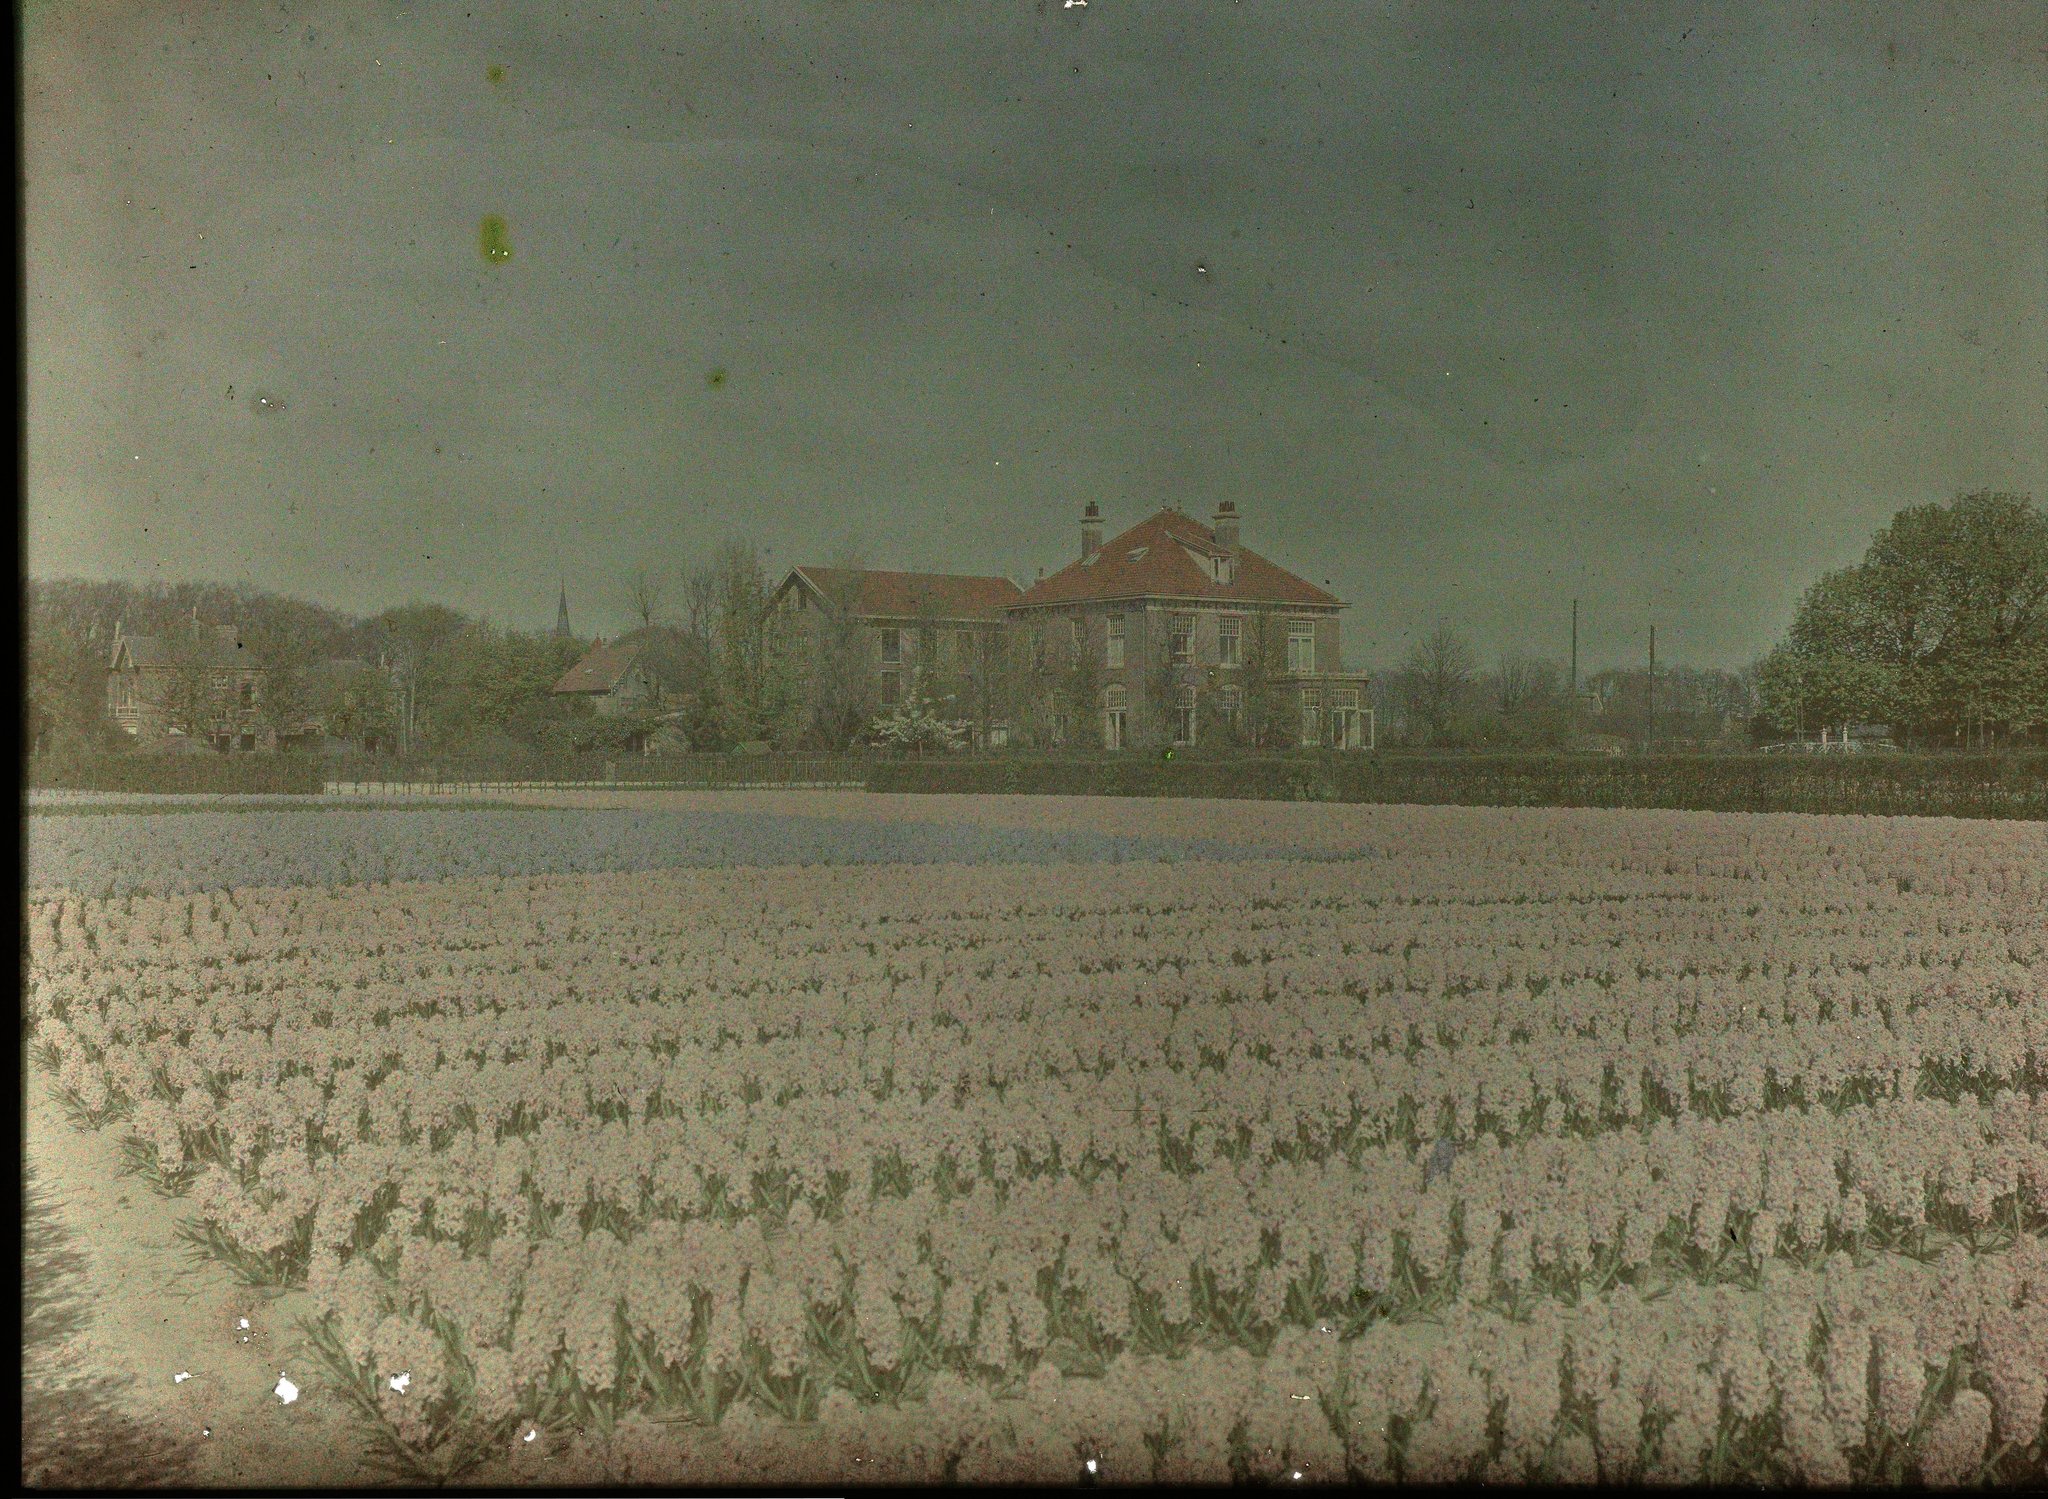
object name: color slide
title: Gezicht op een veld met hyacinthen, met een landhuis op de achtergrond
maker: adolphe burdet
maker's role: fotograaf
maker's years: 1860-1940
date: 1907-1914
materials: glass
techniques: autochrome process, slide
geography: netherlands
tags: overveen